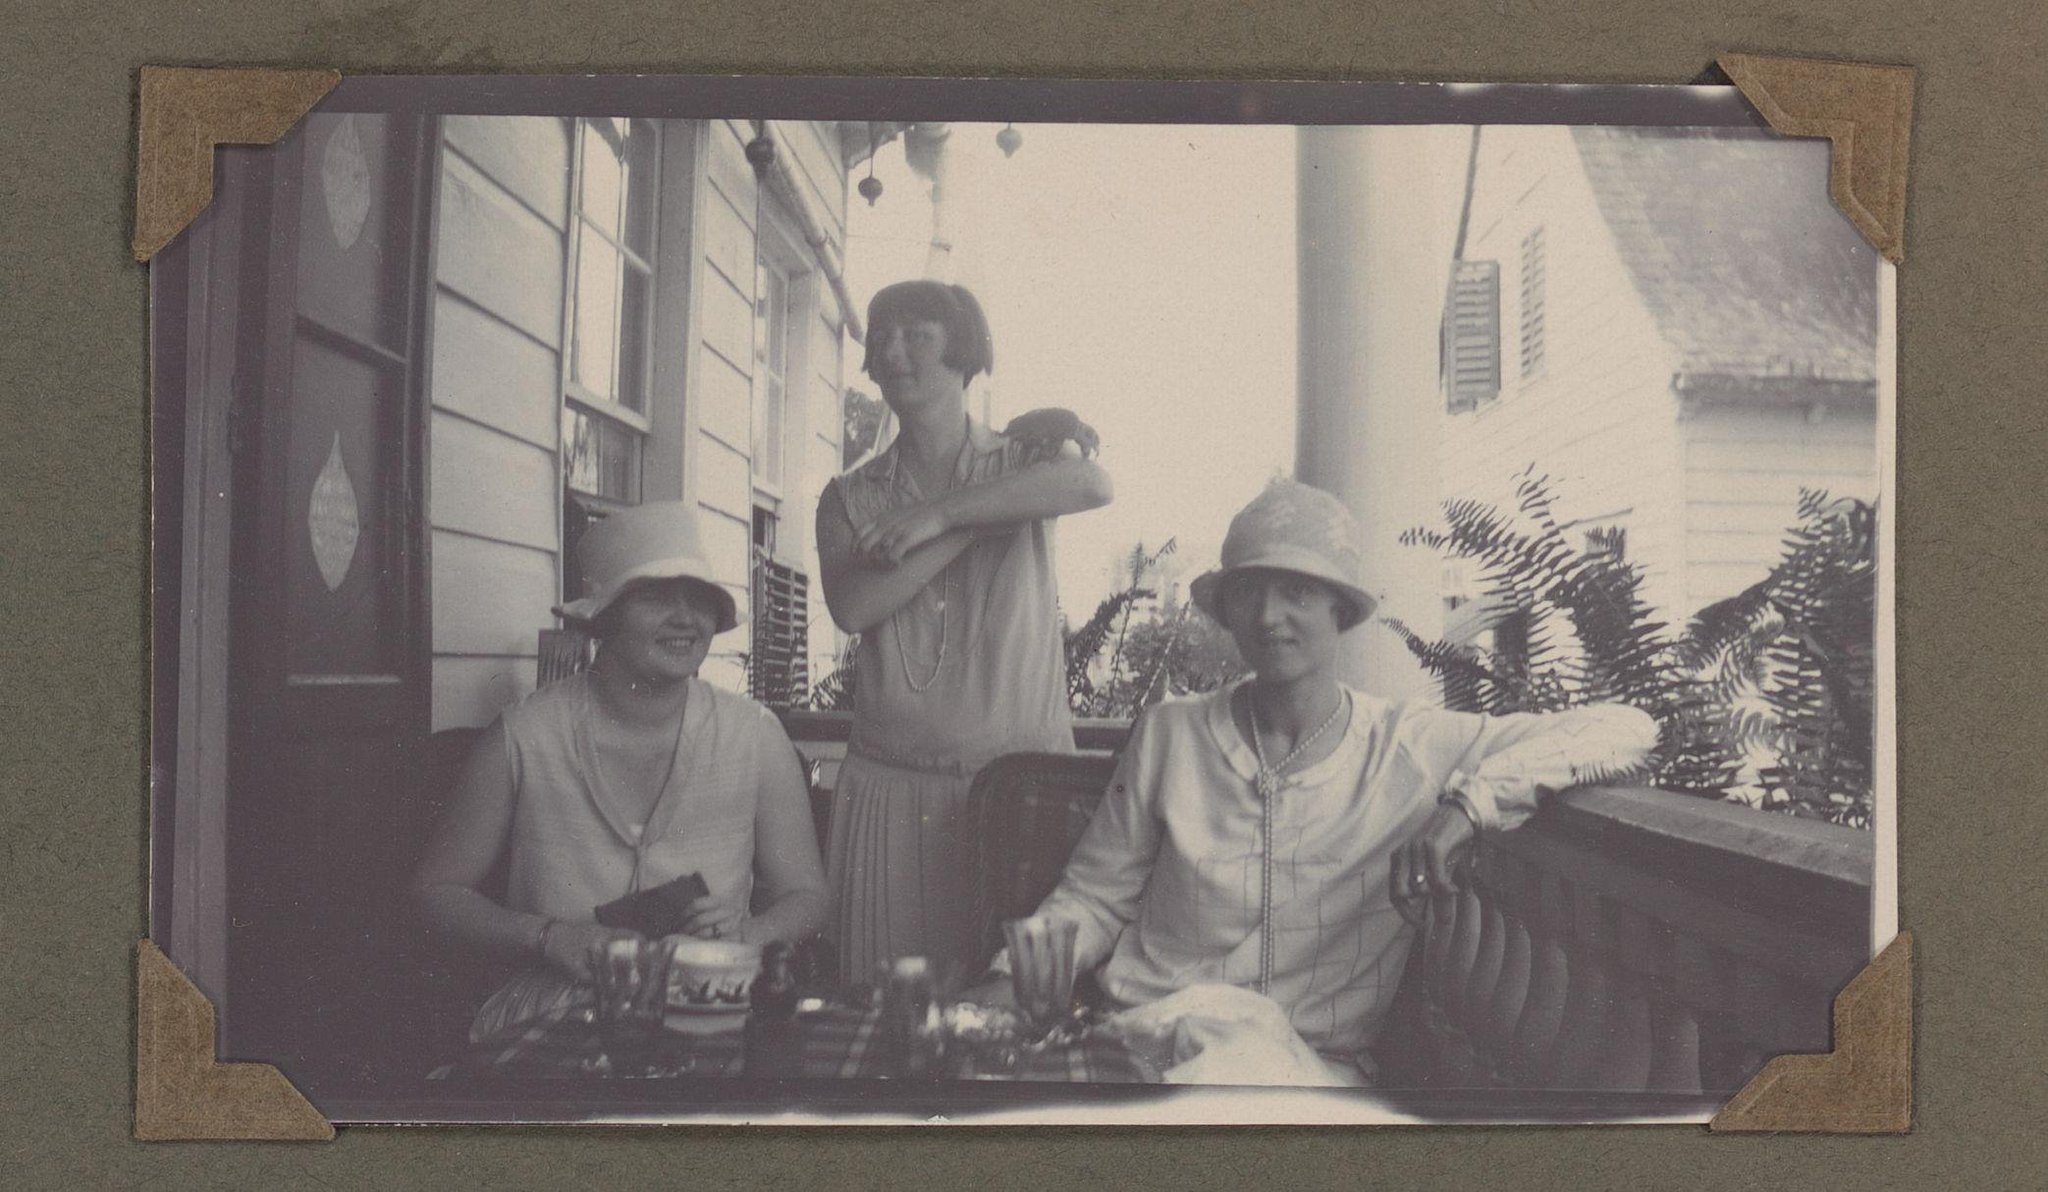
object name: photograph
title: Familiefoto van het gezin Jetten te Moengo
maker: Anonymous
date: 1925-1927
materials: photographic support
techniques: photography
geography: suriname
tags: jetten, familie, moengo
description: Familiefoto van het gezin Jetten te Moengo. Foto op een bladzijde van een los albumblad. Onderdeel van het ensemble met foto's van de familie van ingenieur Jetten in de mijnbouwstad Moengo in Suriname.